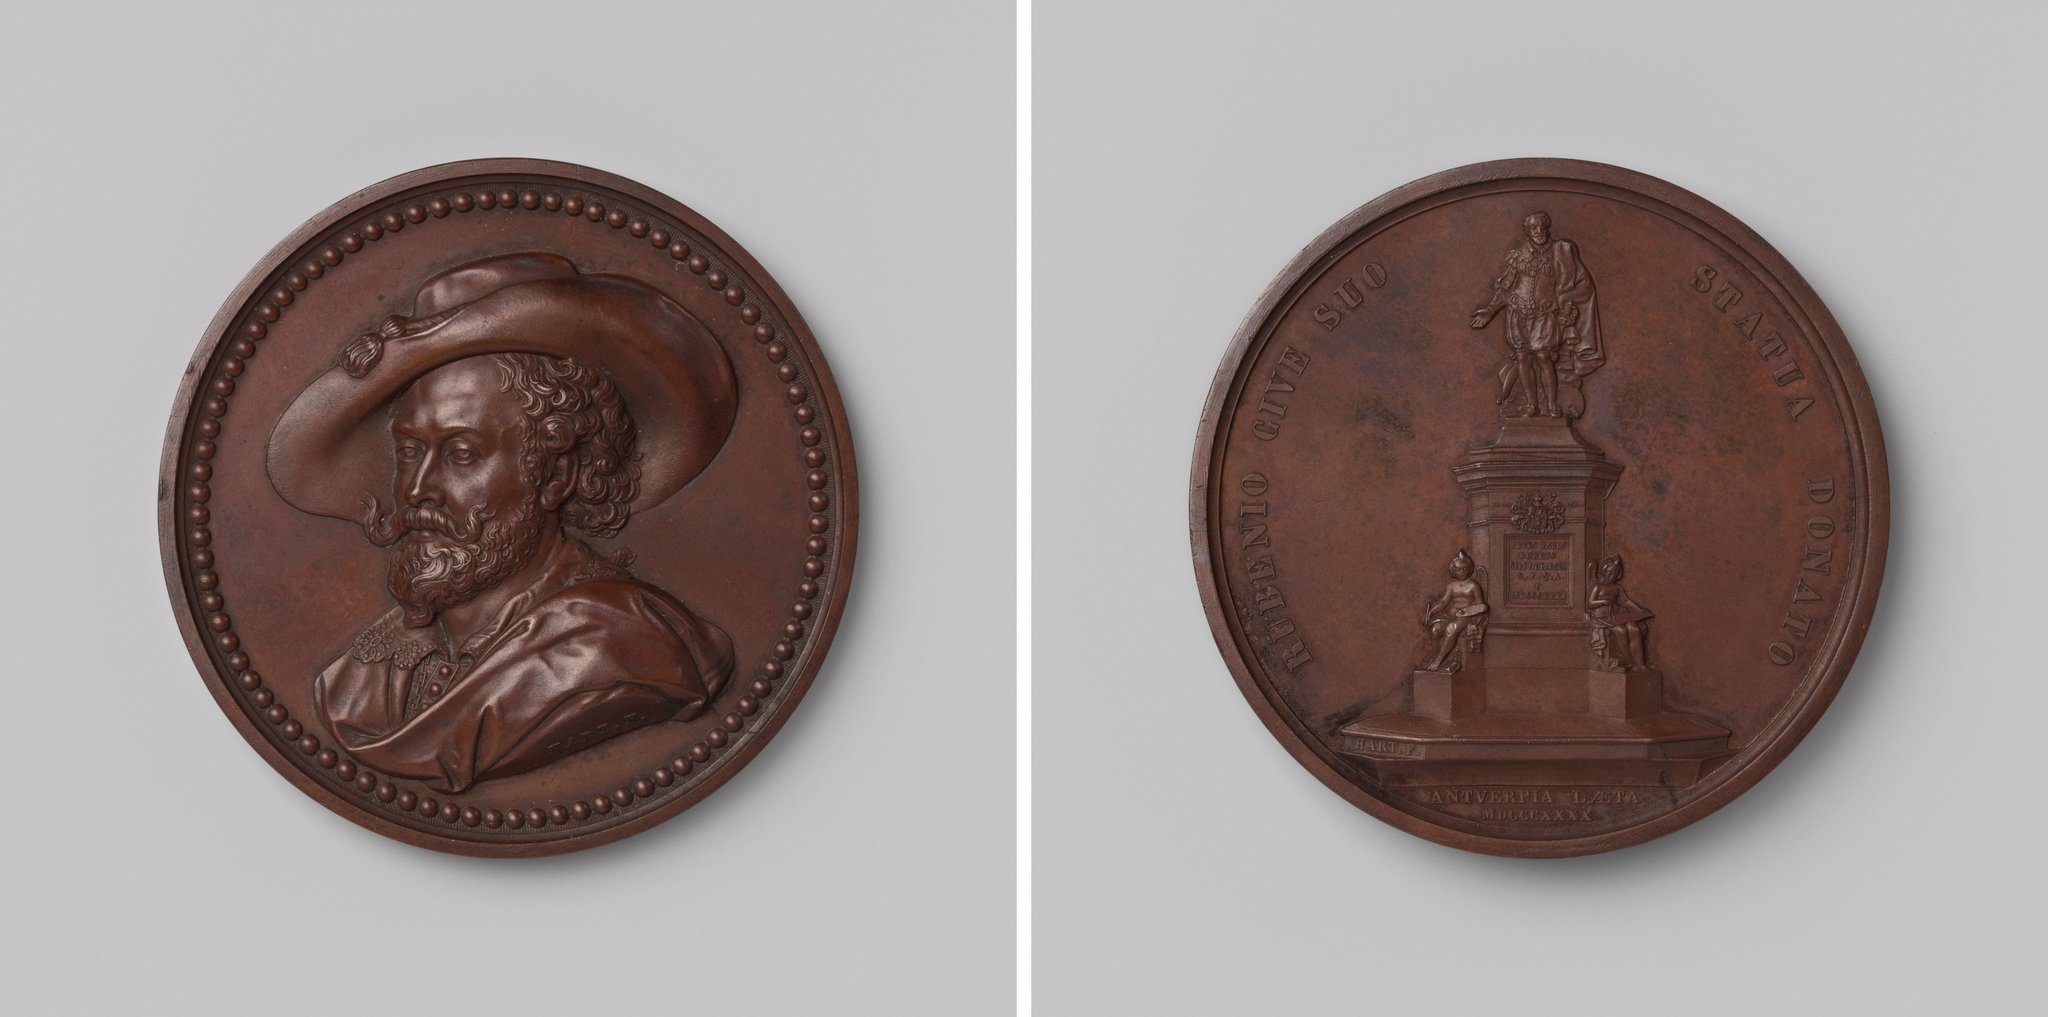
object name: history medal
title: Oprichting van een standbeeld voor de schilder Pieter Paul Rubens te Antwerpen, penning geslagen op last van de stad Antwerpen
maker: laurent joseph hart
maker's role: die cutter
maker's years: 1810-1860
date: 1840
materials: bronze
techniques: striking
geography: brussels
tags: antwerp, painter, print maker, draughtsman, peter paul rubens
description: Bronzen penning. Voorzijde: borststuk man met hoed binnen parelrand. Keerzijde: monument binnen omschrift; afsnede: opschrift.